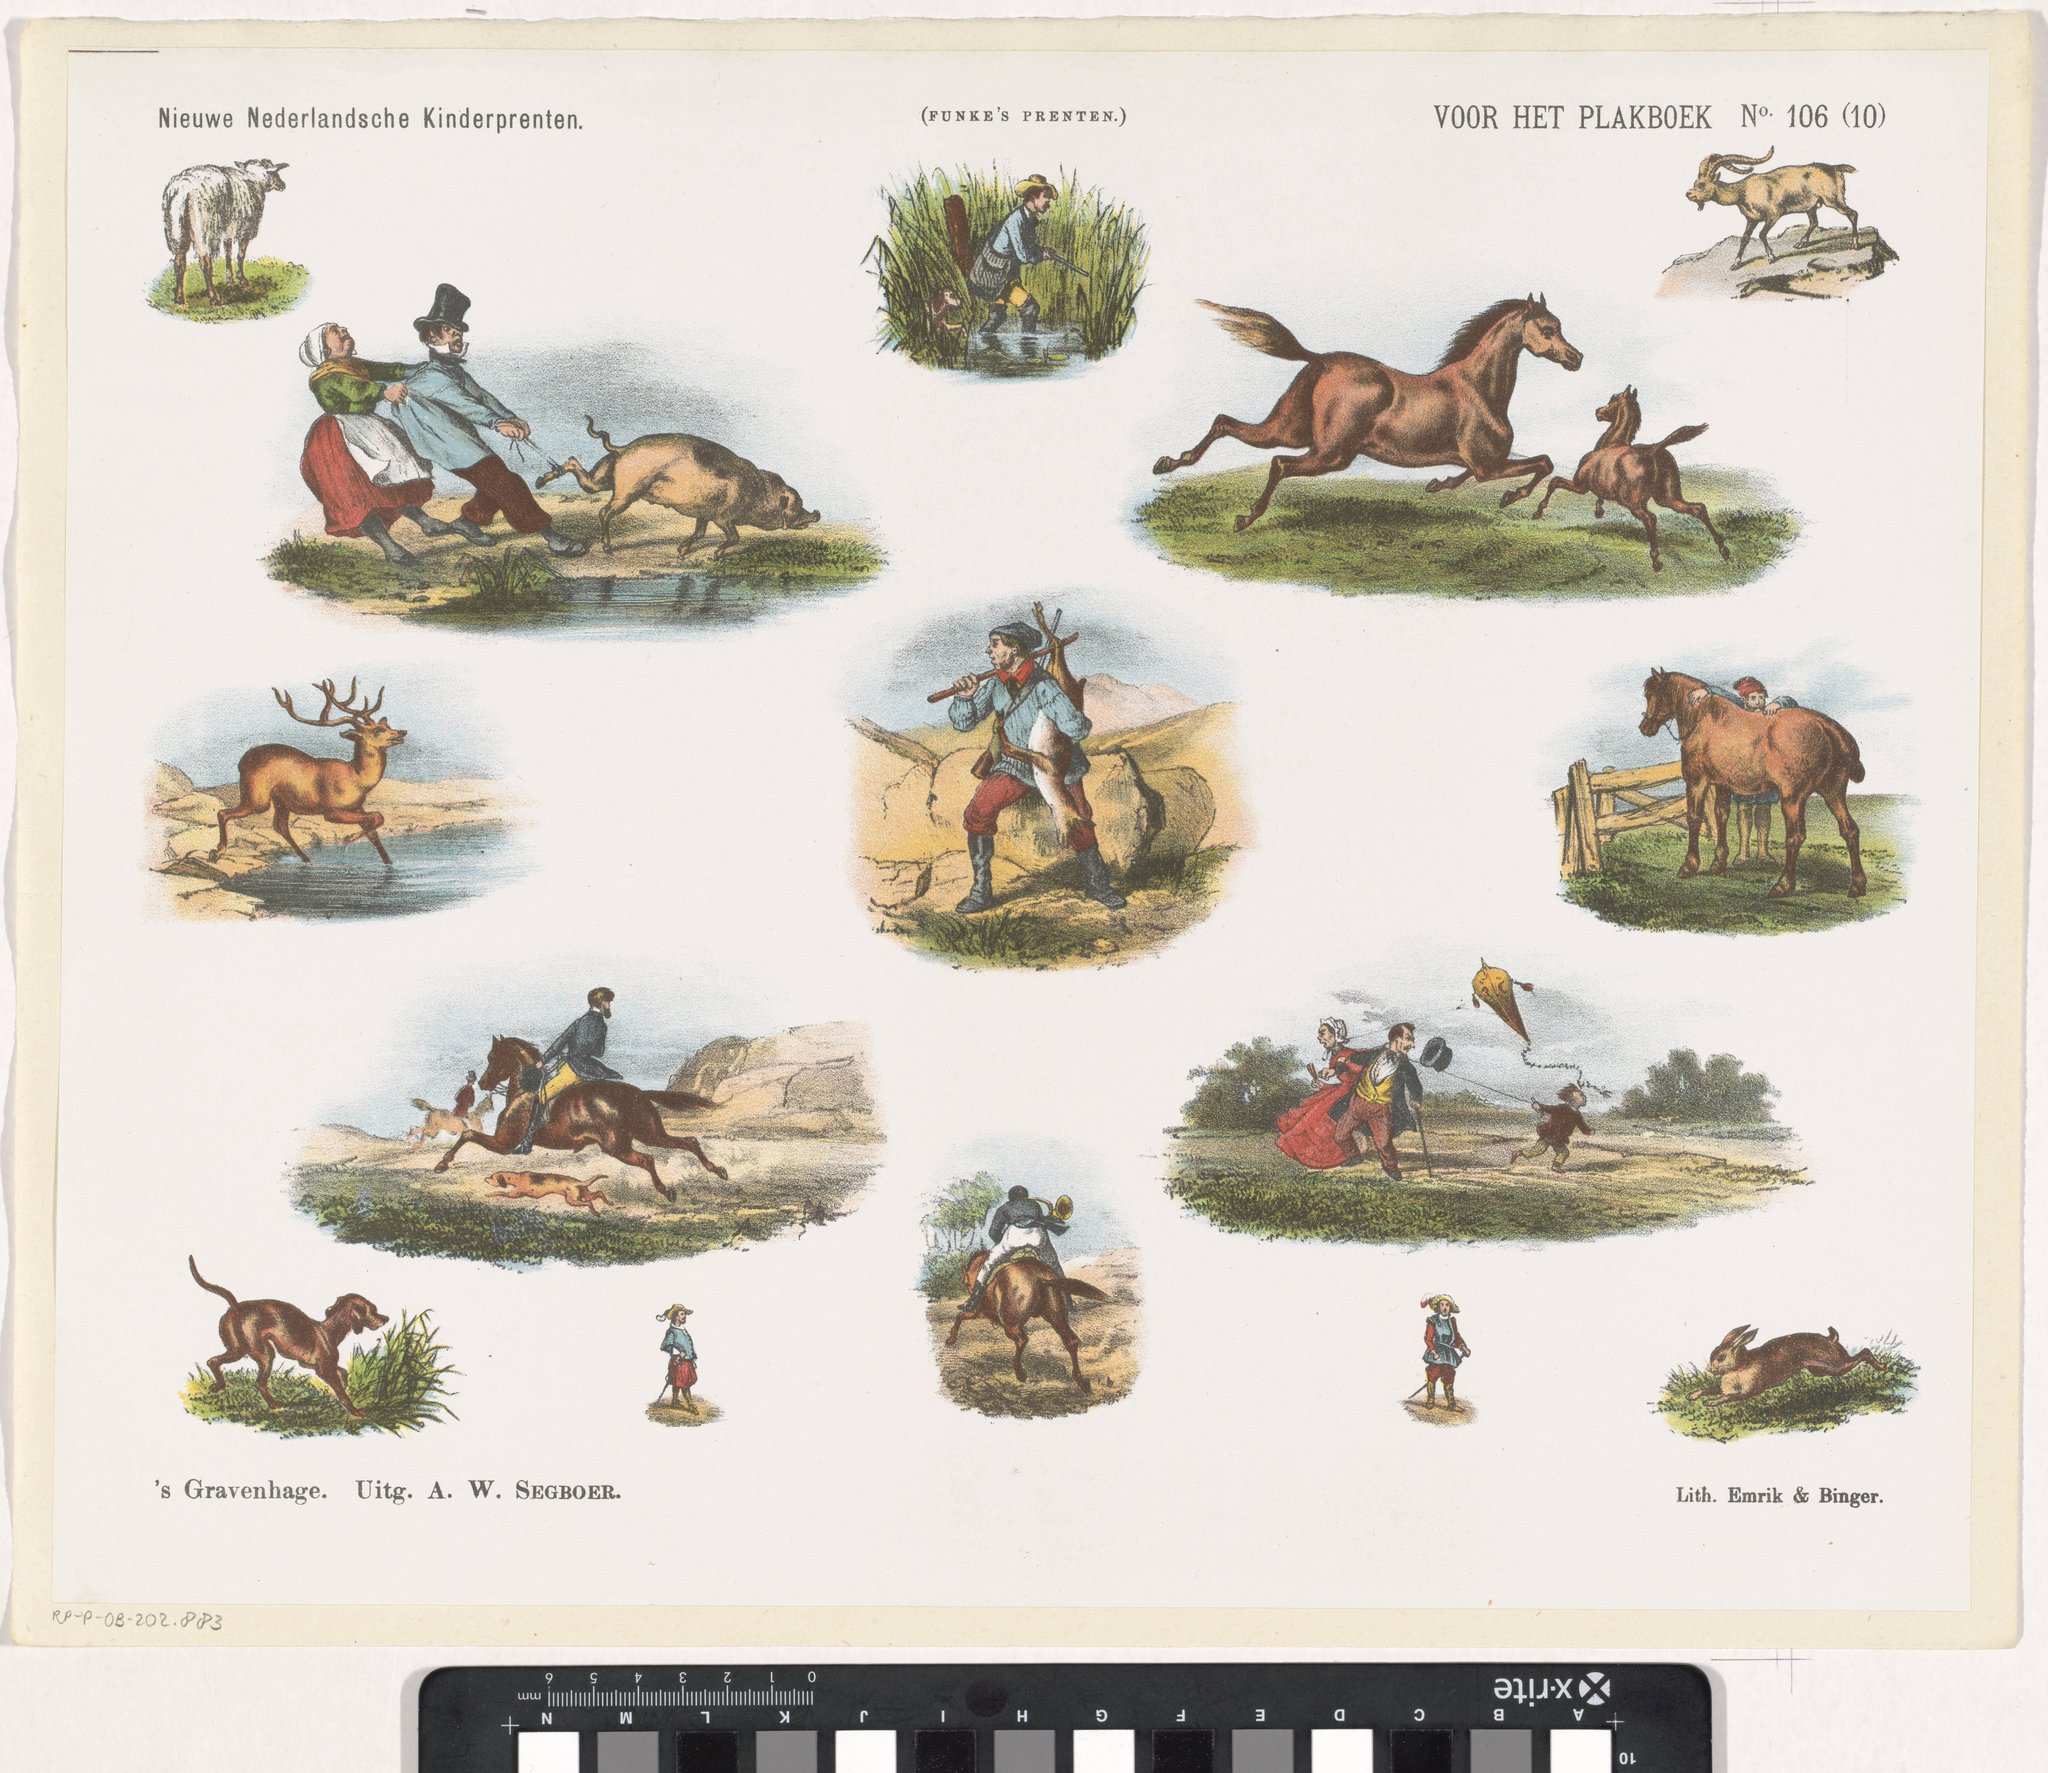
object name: popular print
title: Funke's prenten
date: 1903-1919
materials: paper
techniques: lithograph, letterpress printing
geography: the hague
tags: animals, hunt ~ mammals, horse, (flying a) kite, dog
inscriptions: collector's mark: Lugt 2760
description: Blad met 15 voorstellingen van verschillende aard, waaronder voorstellingen van dieren, jagers en een vliegerend jongetje. Genummerd rechtsboven: No. 106.